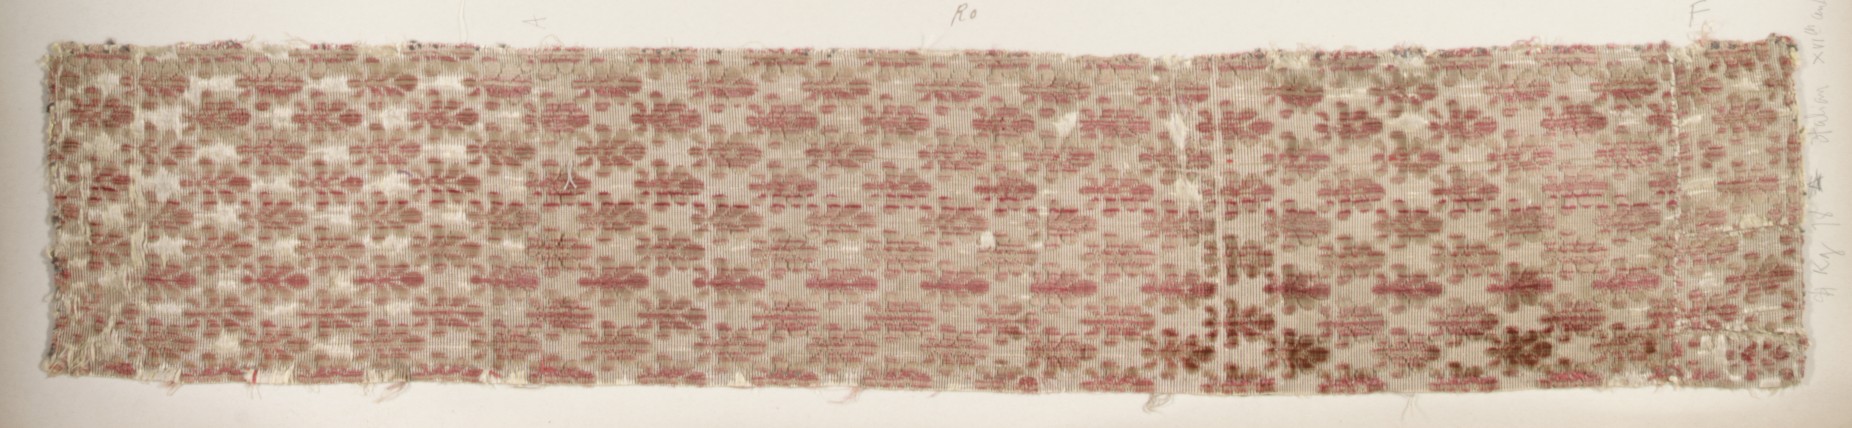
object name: fragment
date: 1601-1800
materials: silk